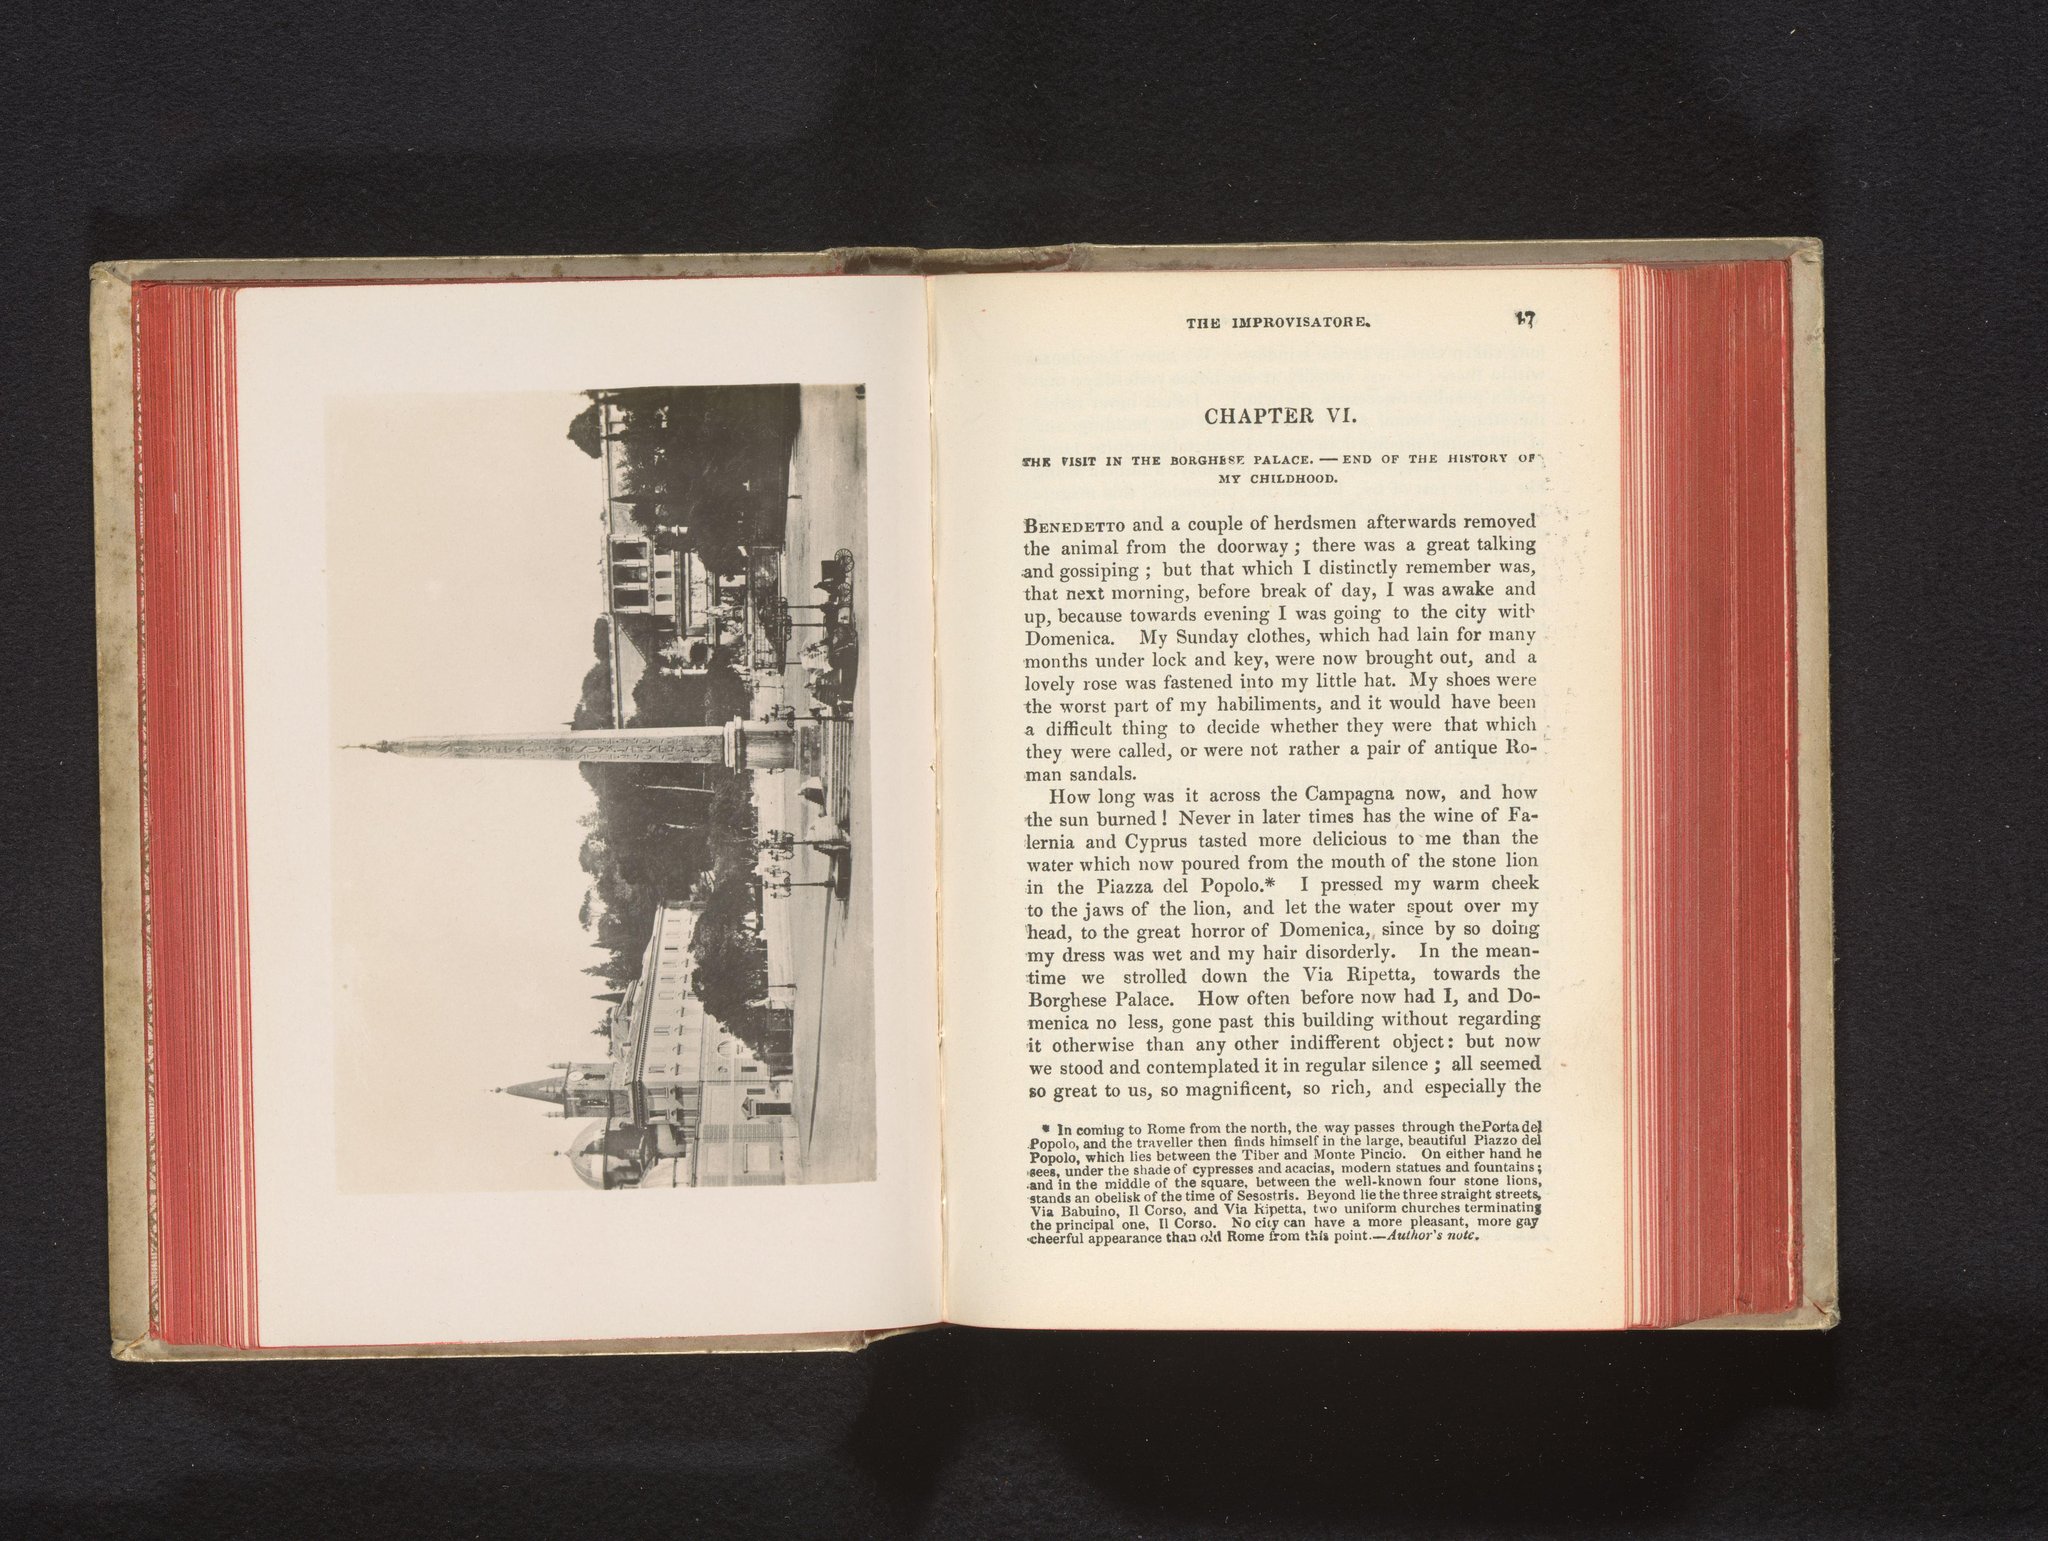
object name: page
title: Obelisk op het Piazza del Popolo te Rome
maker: Anonymous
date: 1870-1880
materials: photographic support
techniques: gelatin silver print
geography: piazza del popolo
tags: square, place, circus, etc., obelisk, needle